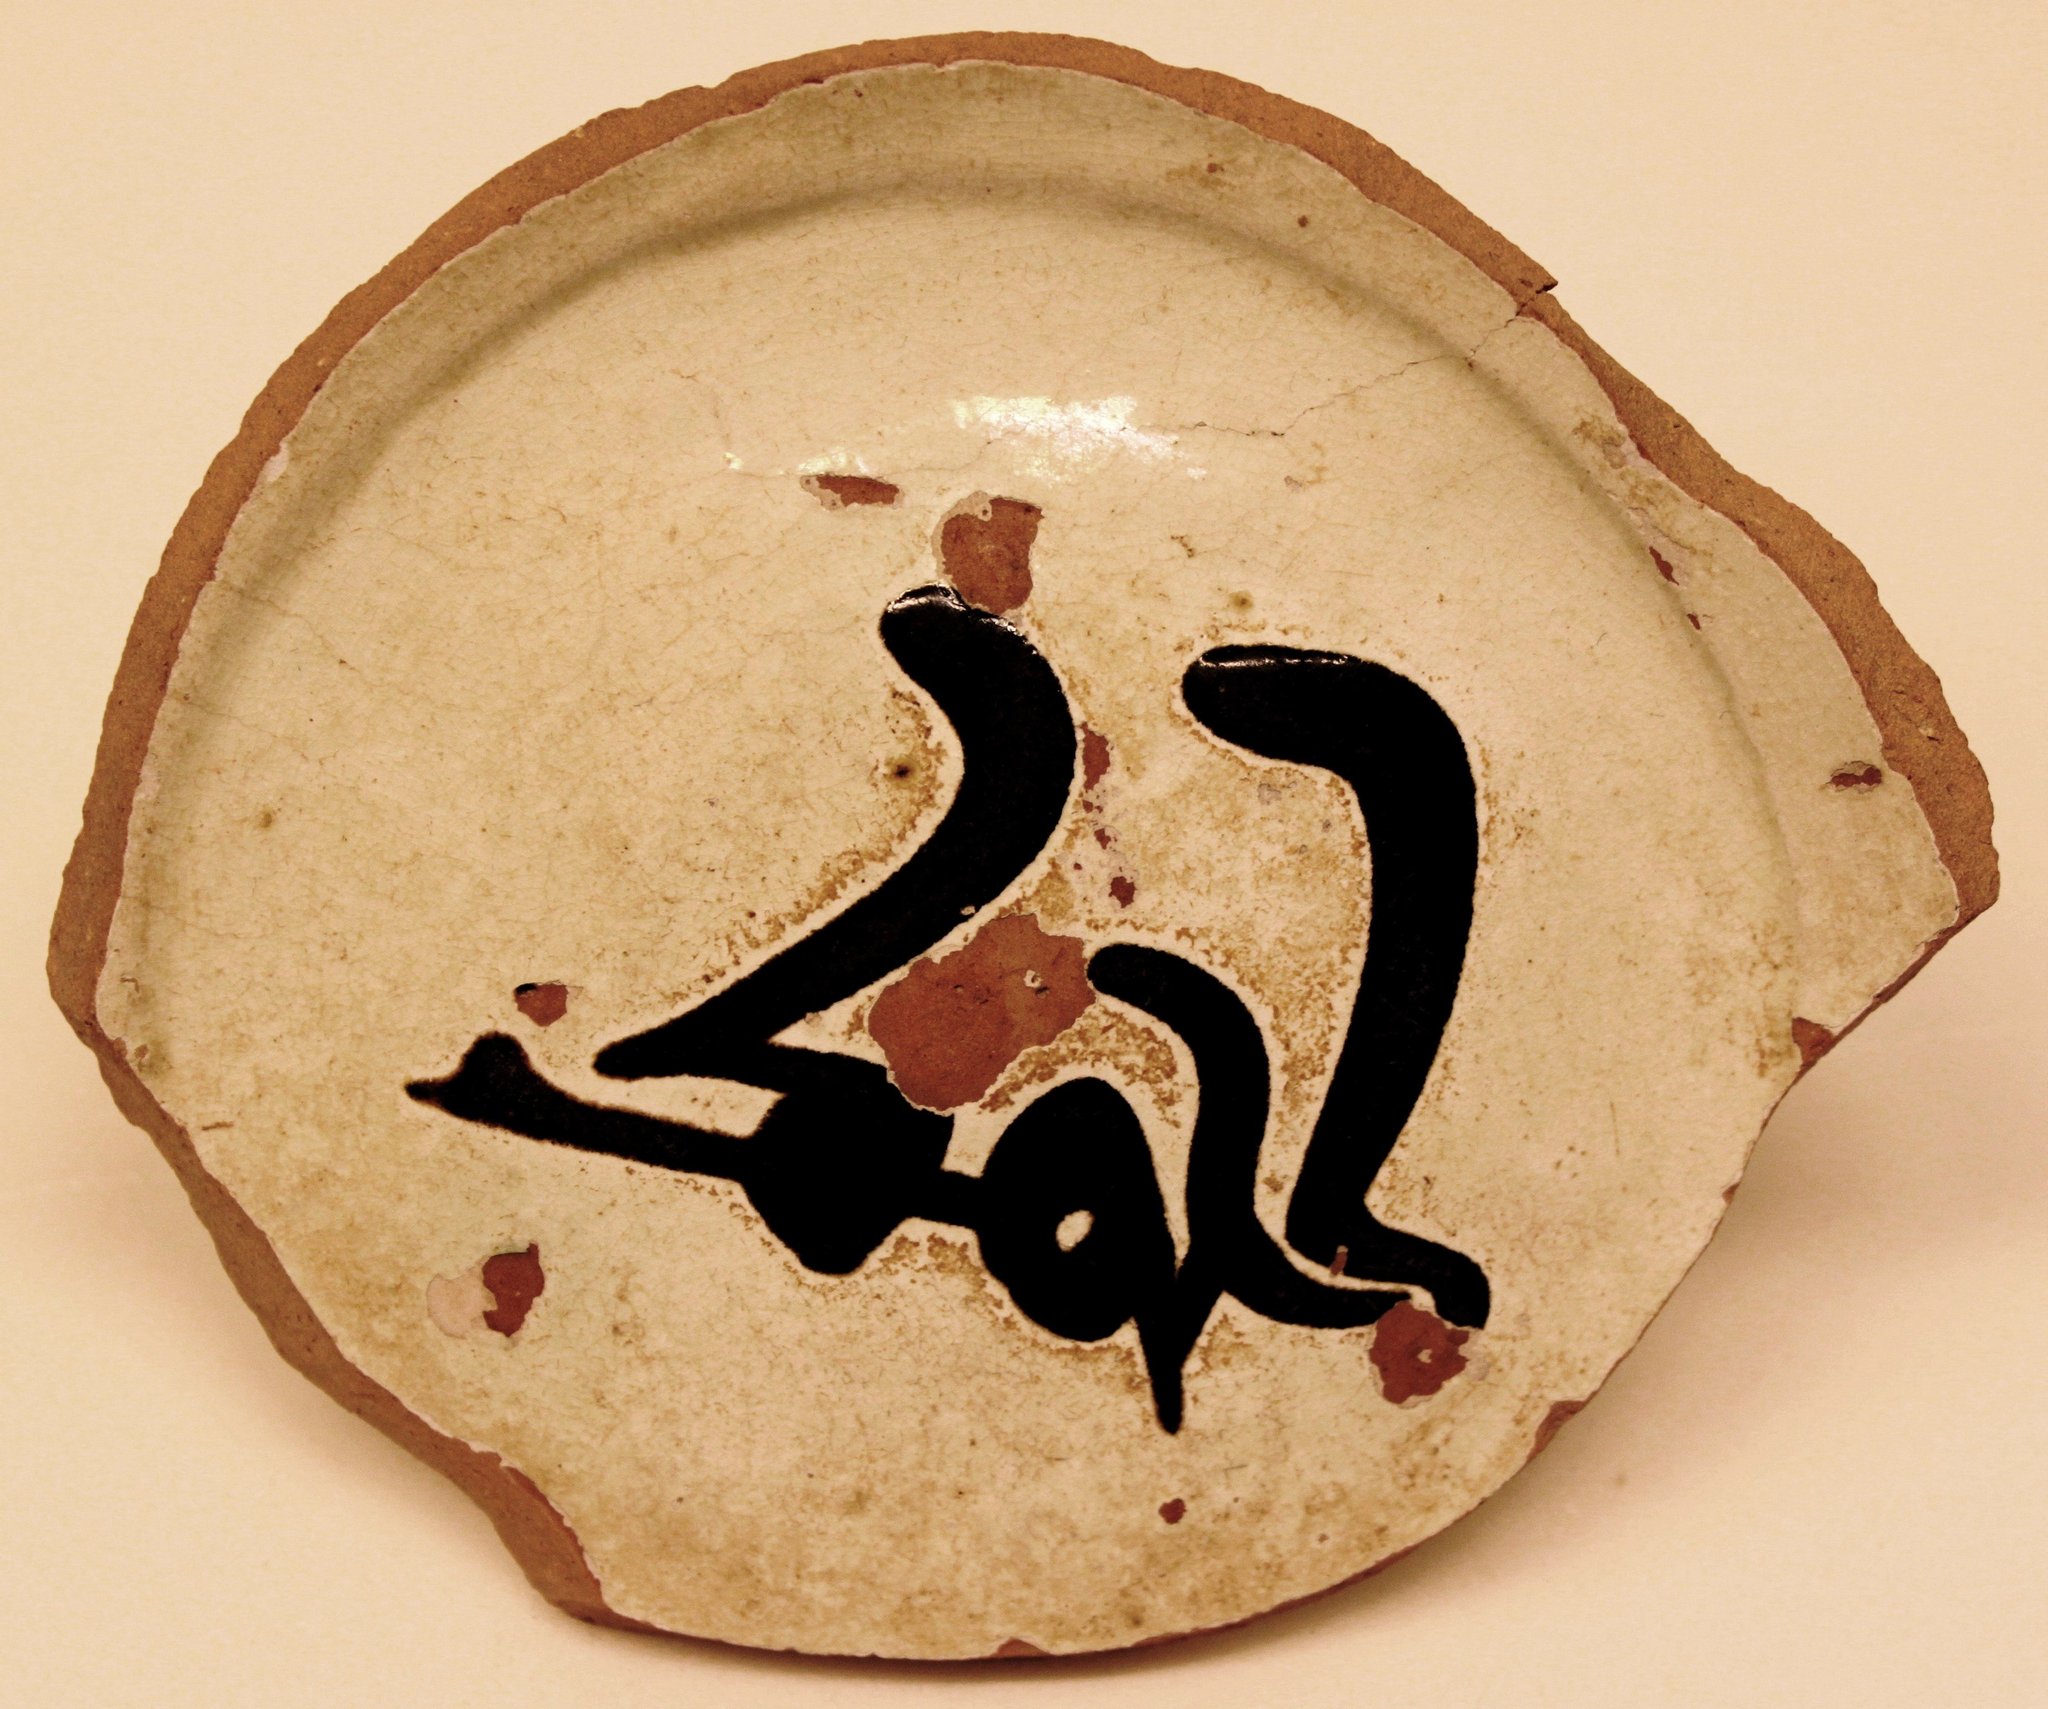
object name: ceramic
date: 701-1200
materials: earthenware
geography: iran